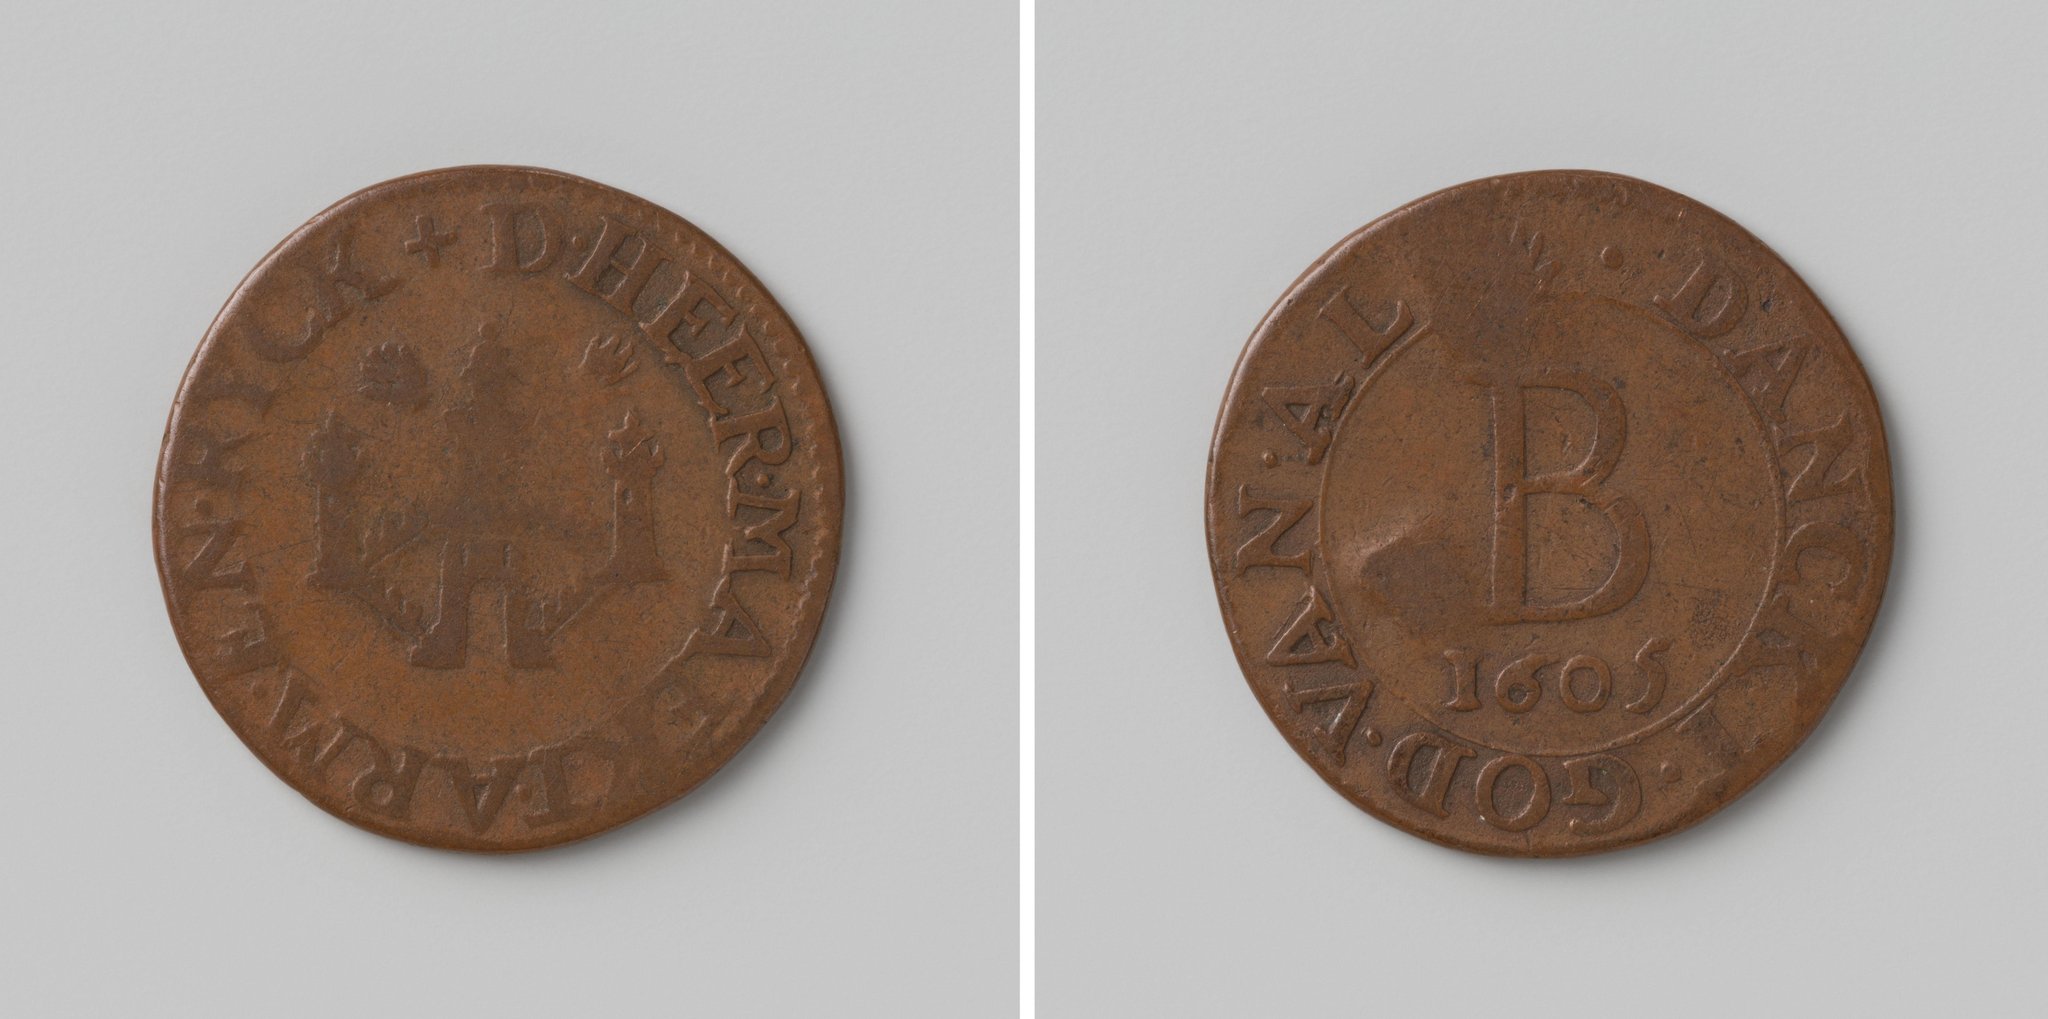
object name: bread token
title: Stad Antwerpen, loodje dat bij uitdeling recht gaf op brood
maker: Anonymous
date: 1605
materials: copper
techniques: striking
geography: antwerp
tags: antwerp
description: Koperen penning. Voorzijde: twee geopende handen boven burcht binnen omschrift. Keerzijde: letter B boven jaartal binnen omschrift